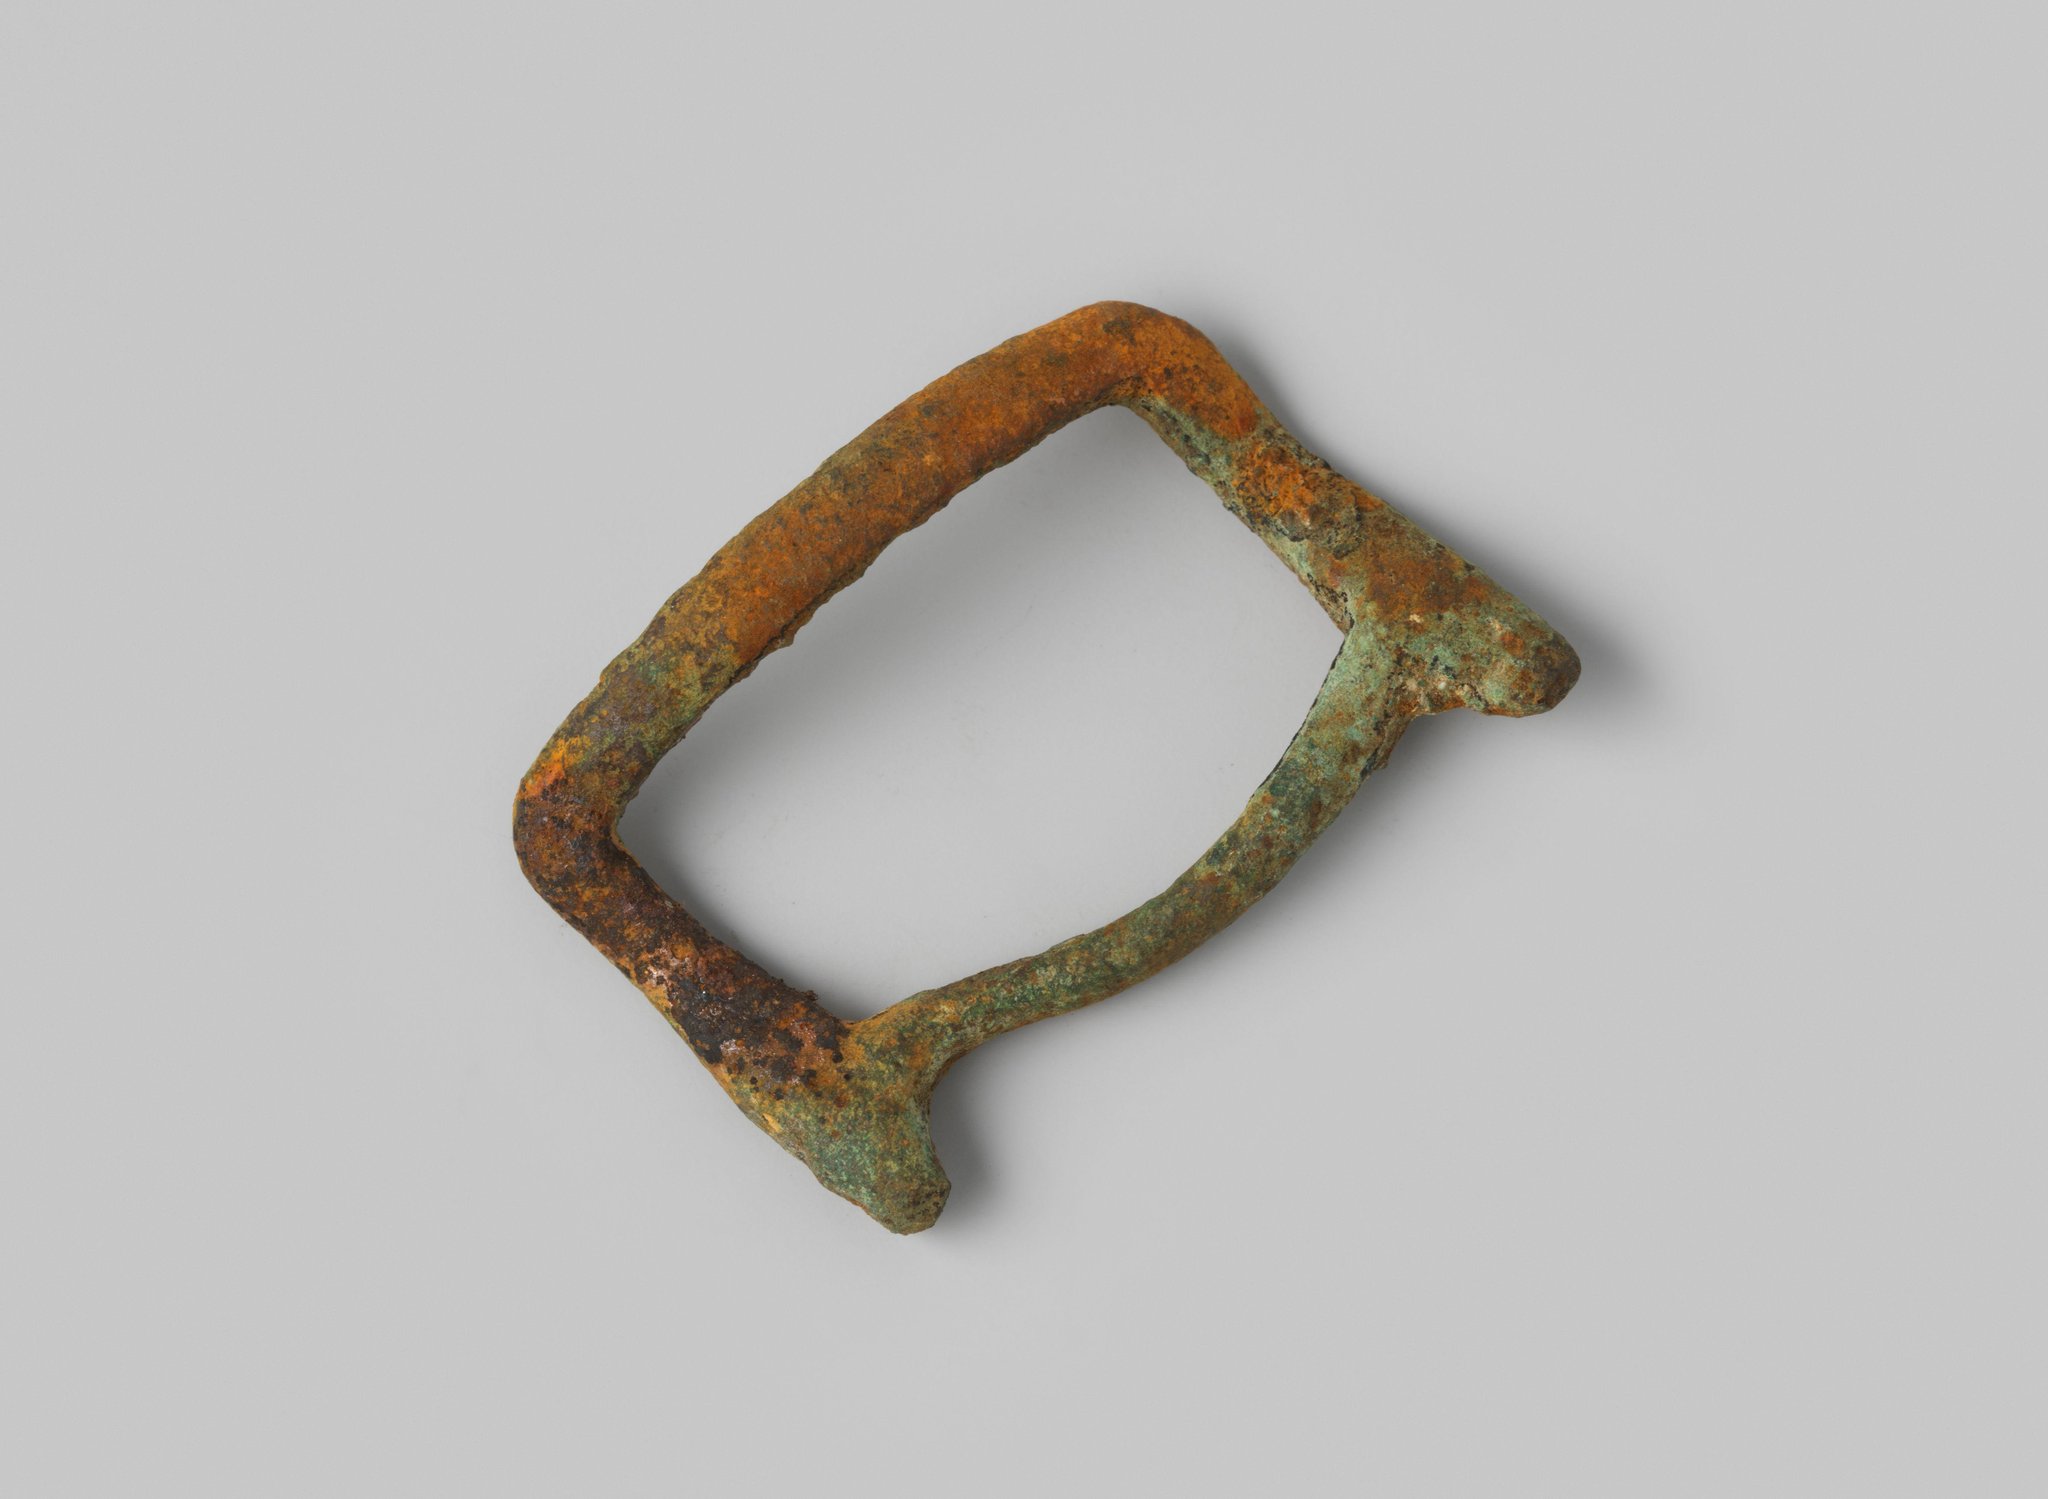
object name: belt buckle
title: Fragment riemgesp uit het wrak van de Oost-Indiëvaarder Hollandia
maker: Anonymous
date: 1700-1743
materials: copper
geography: netherlands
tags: verenigde oostindische compagnie, hollandia (schip), annet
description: D-shaped with pointed side, fragm of ring and spindle, id. NG 1980-27H384, belt buckle.